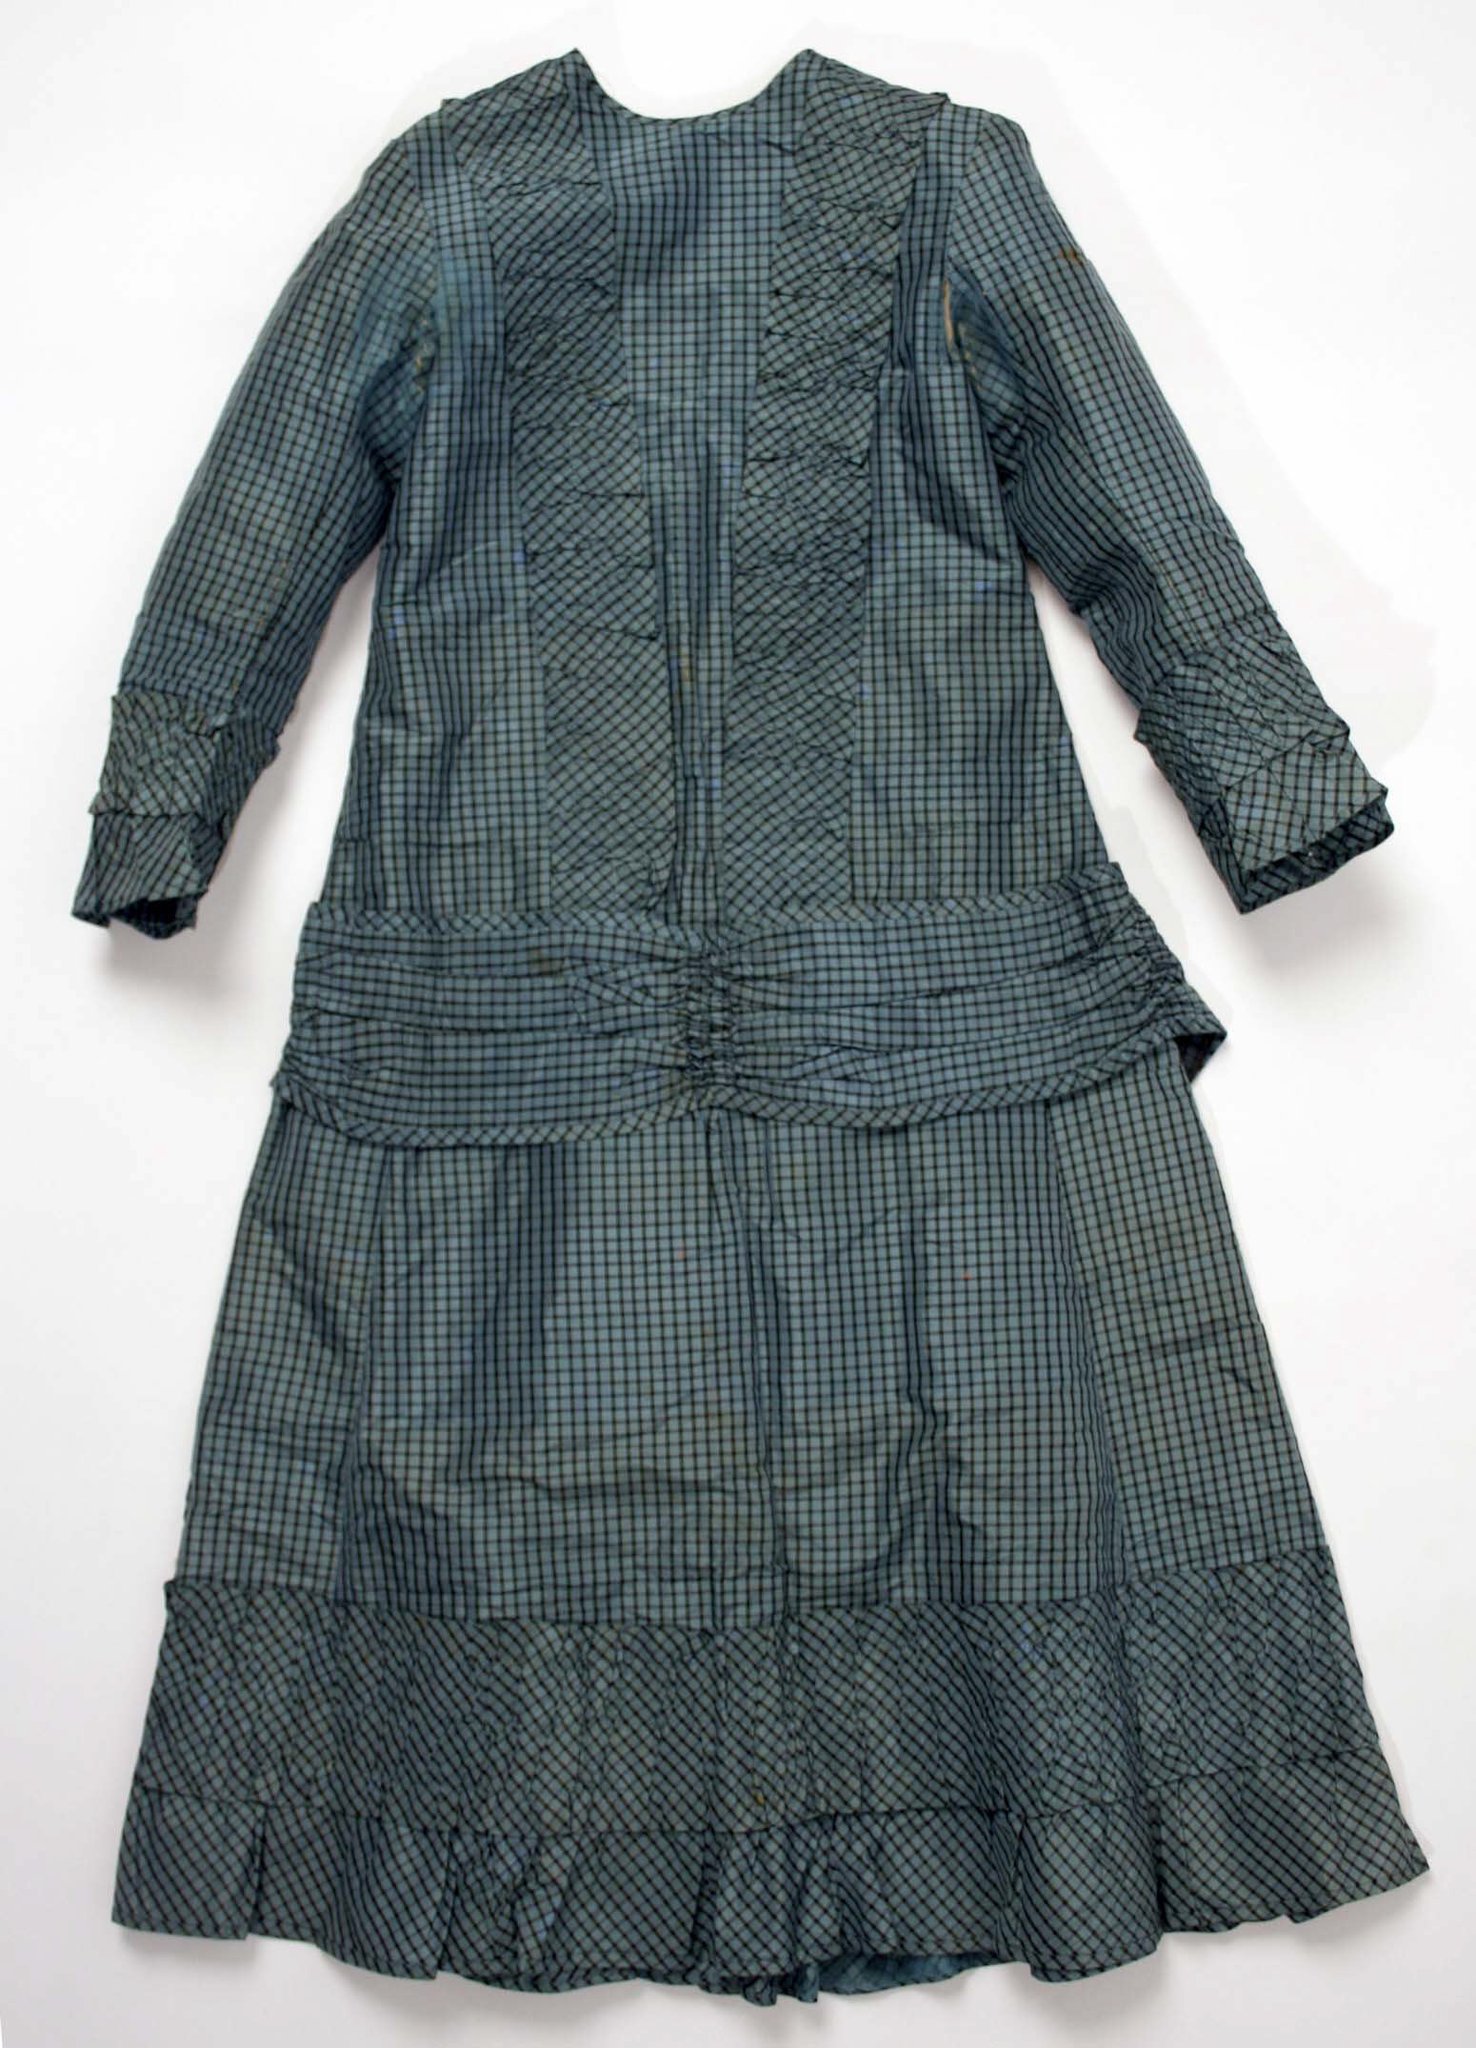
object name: dress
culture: american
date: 1882-1885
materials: silk